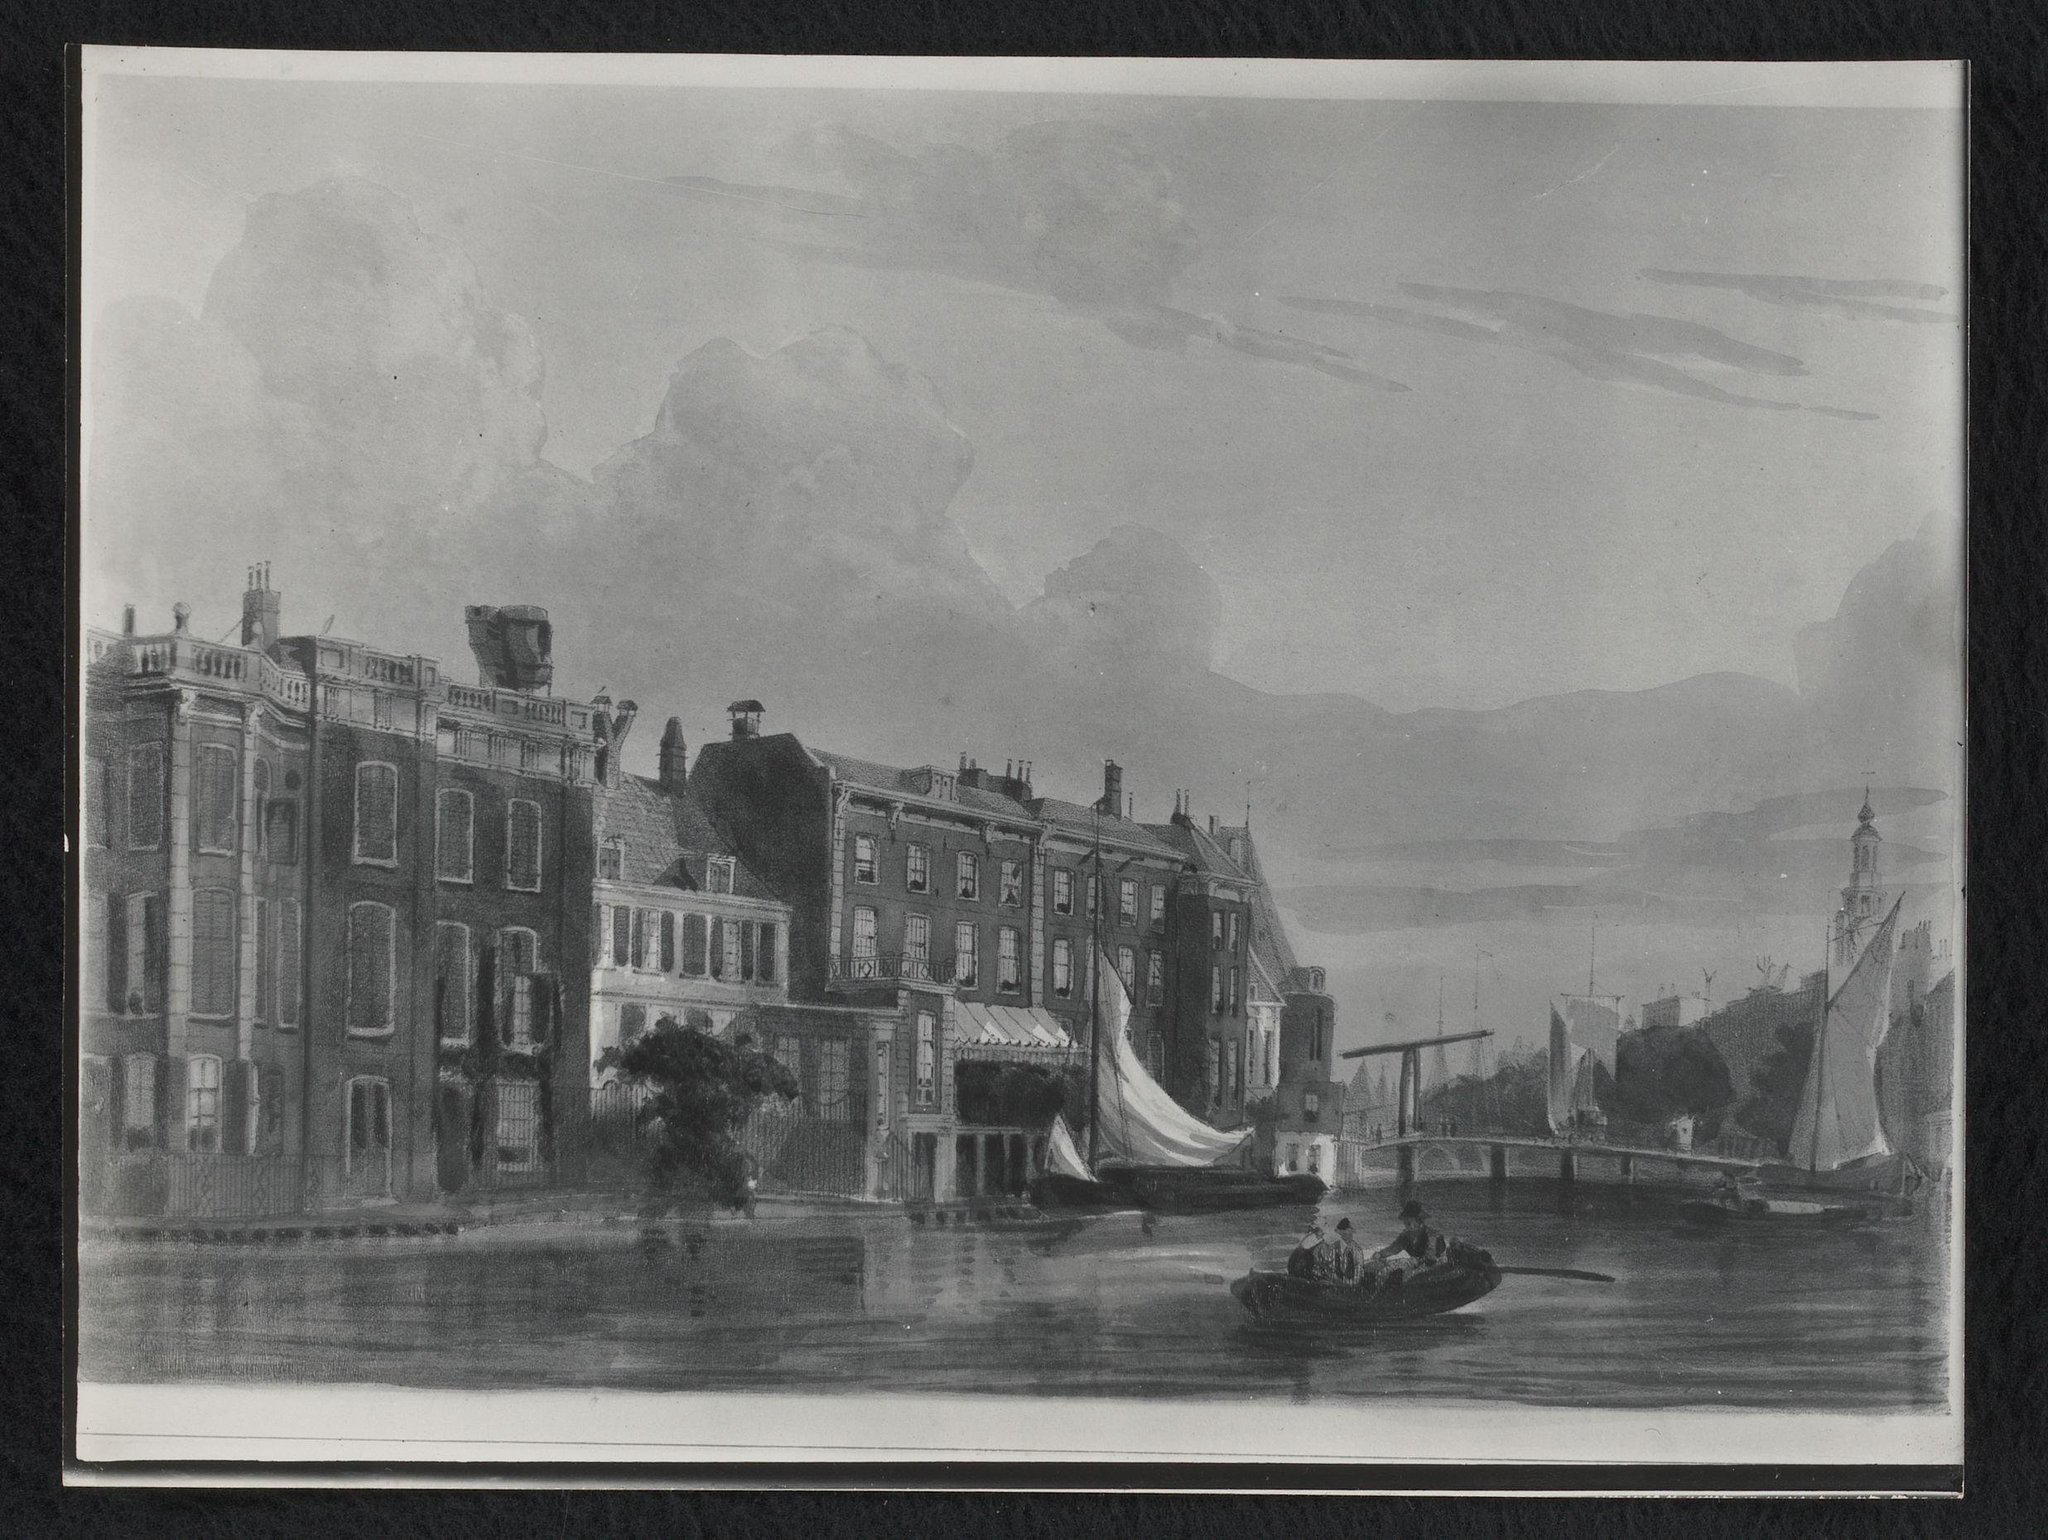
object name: photograph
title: Zes foto's van het Rokin en de Munt, Amsterdam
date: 1900-1931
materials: paper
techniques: gelatin silver print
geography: amsterdam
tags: canals, waters (in city), street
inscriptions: inscription: ‘gezicht o.d. Nederl. Bank’, inscription: ‘Rokin percelen van de Nederlandsche/ Bank, architect Vingsboons 17e eeuw’, inscription: ‘Museum Willet-Holthuijsen/ Heerengracht 605’, inscription: ‘Kerk "het Boompje" met het Badhuis/ a.h. Rokin/ (begin 1900)’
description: Deze foto's maken deel uit van een album.